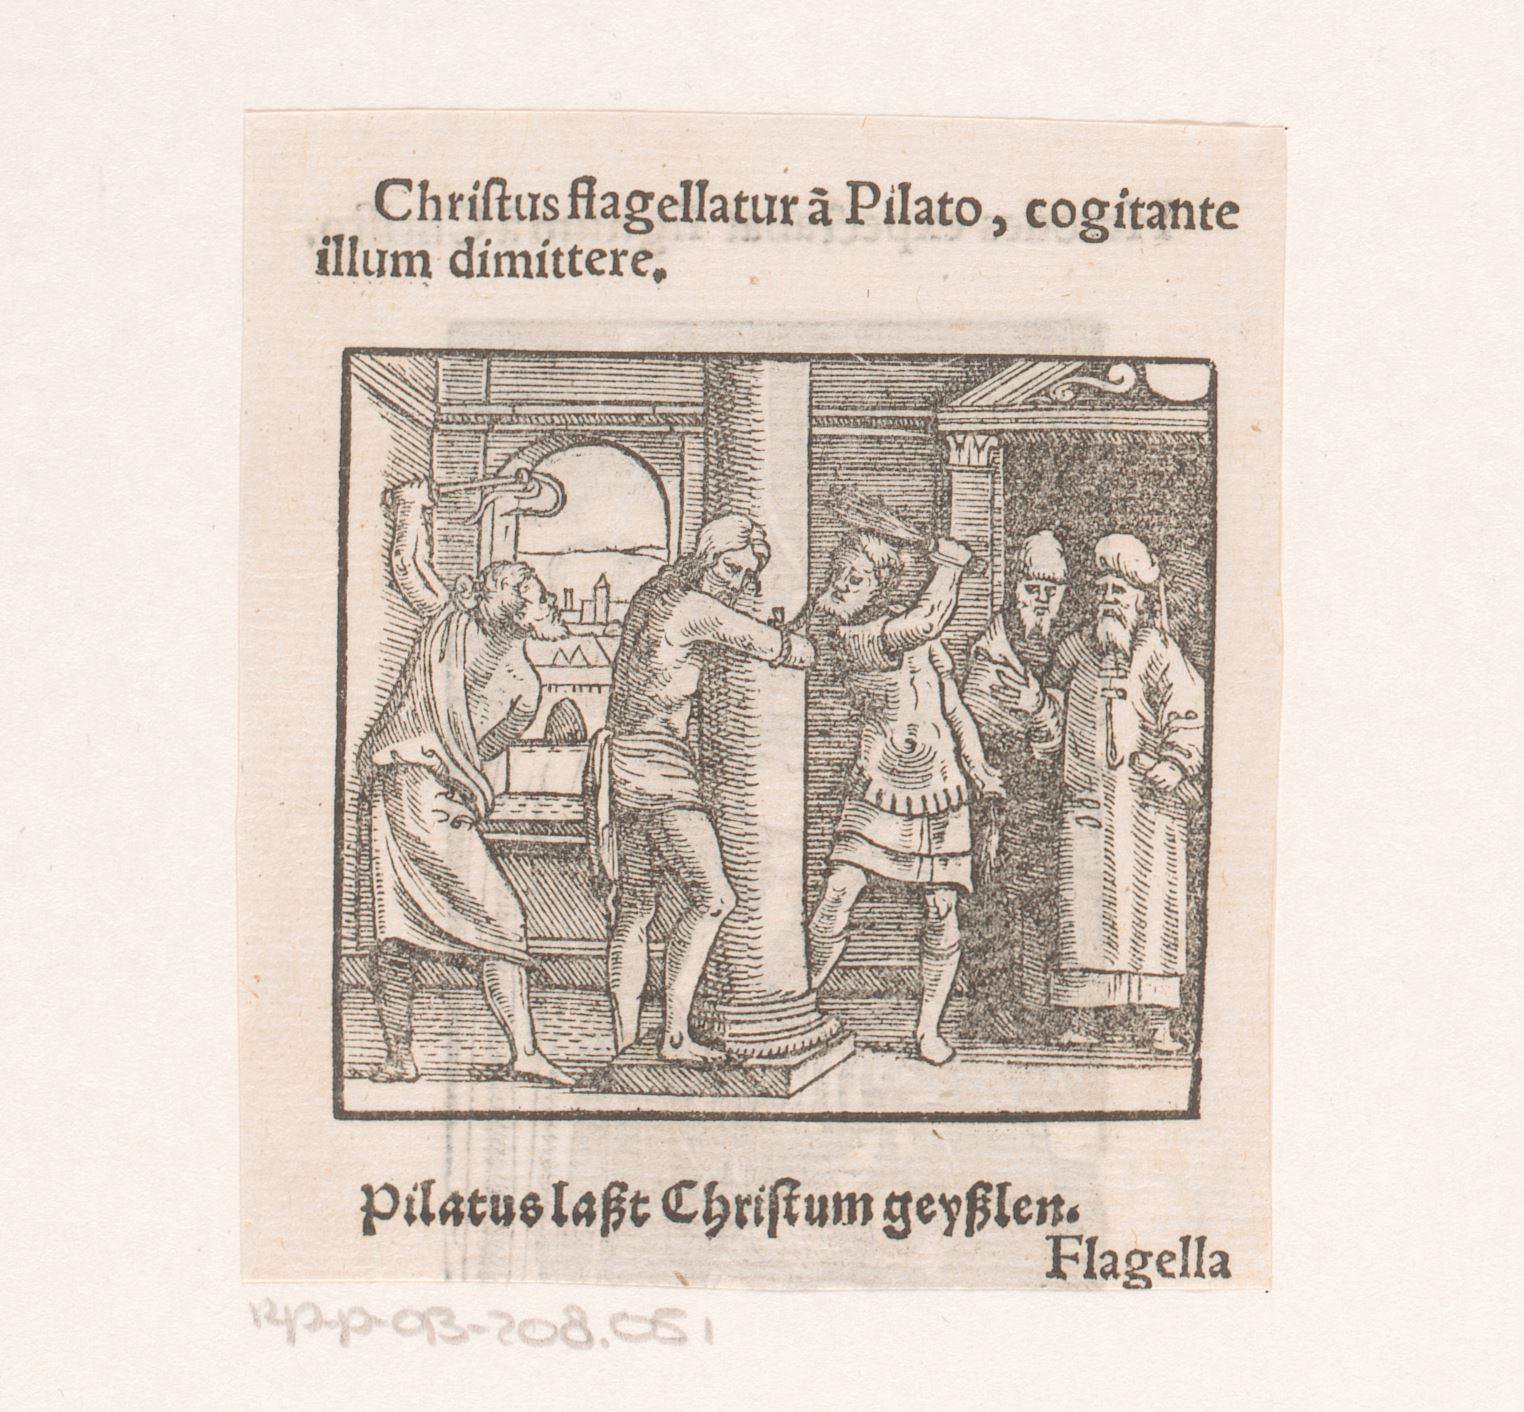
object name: book illustration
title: Geseling van Christus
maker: Anonymous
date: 1600-1699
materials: paper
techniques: letterpress printing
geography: netherlands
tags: flagellation by soldiers, christ usually tied to a column (matthew 27:26; mark 15:15; john 19:1)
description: Christus, gekleed in een lendendoek en vastgebonden aan een pilaar, wordt door twee mannen geslagen met een gesel en een roede.